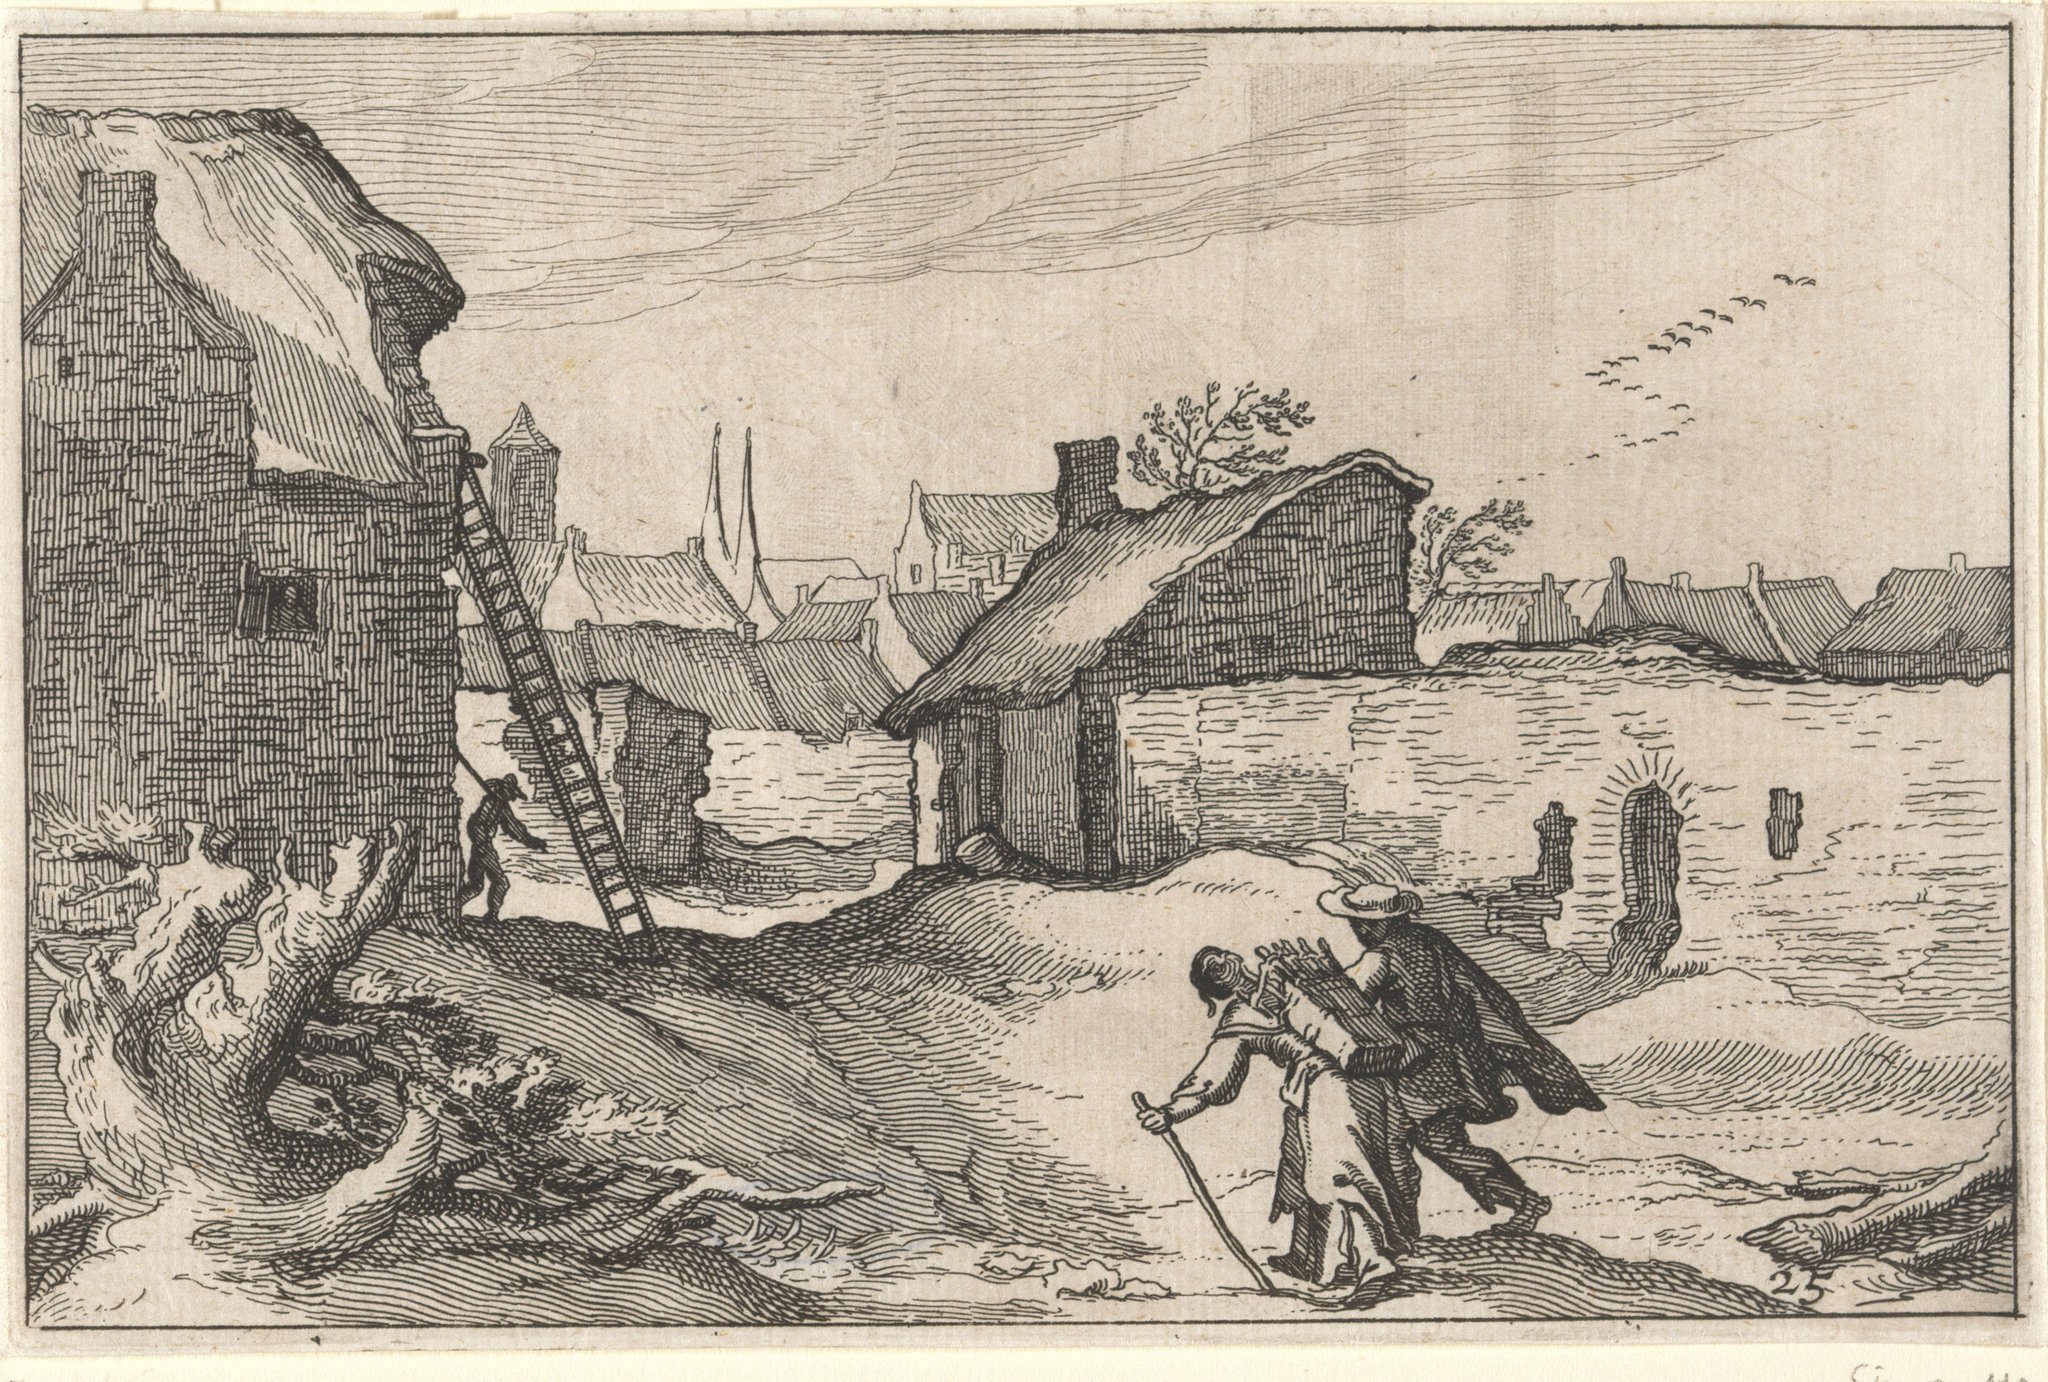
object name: print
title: Landschappen met boerderijen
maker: claes jansz. visscher (ii)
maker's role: draughtsman, print maker, publisher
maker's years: 1586-1652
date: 1620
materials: paper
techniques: etching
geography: amsterdam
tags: landscapes, public road in village, farm or solitary house in landscape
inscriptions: collector's mark: 2228, number: ‘25’ Lugt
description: Twee mannen wandelen richting een boerderij, welke aan de rand van een stad ligt. In de lucht een zwerm vogels.